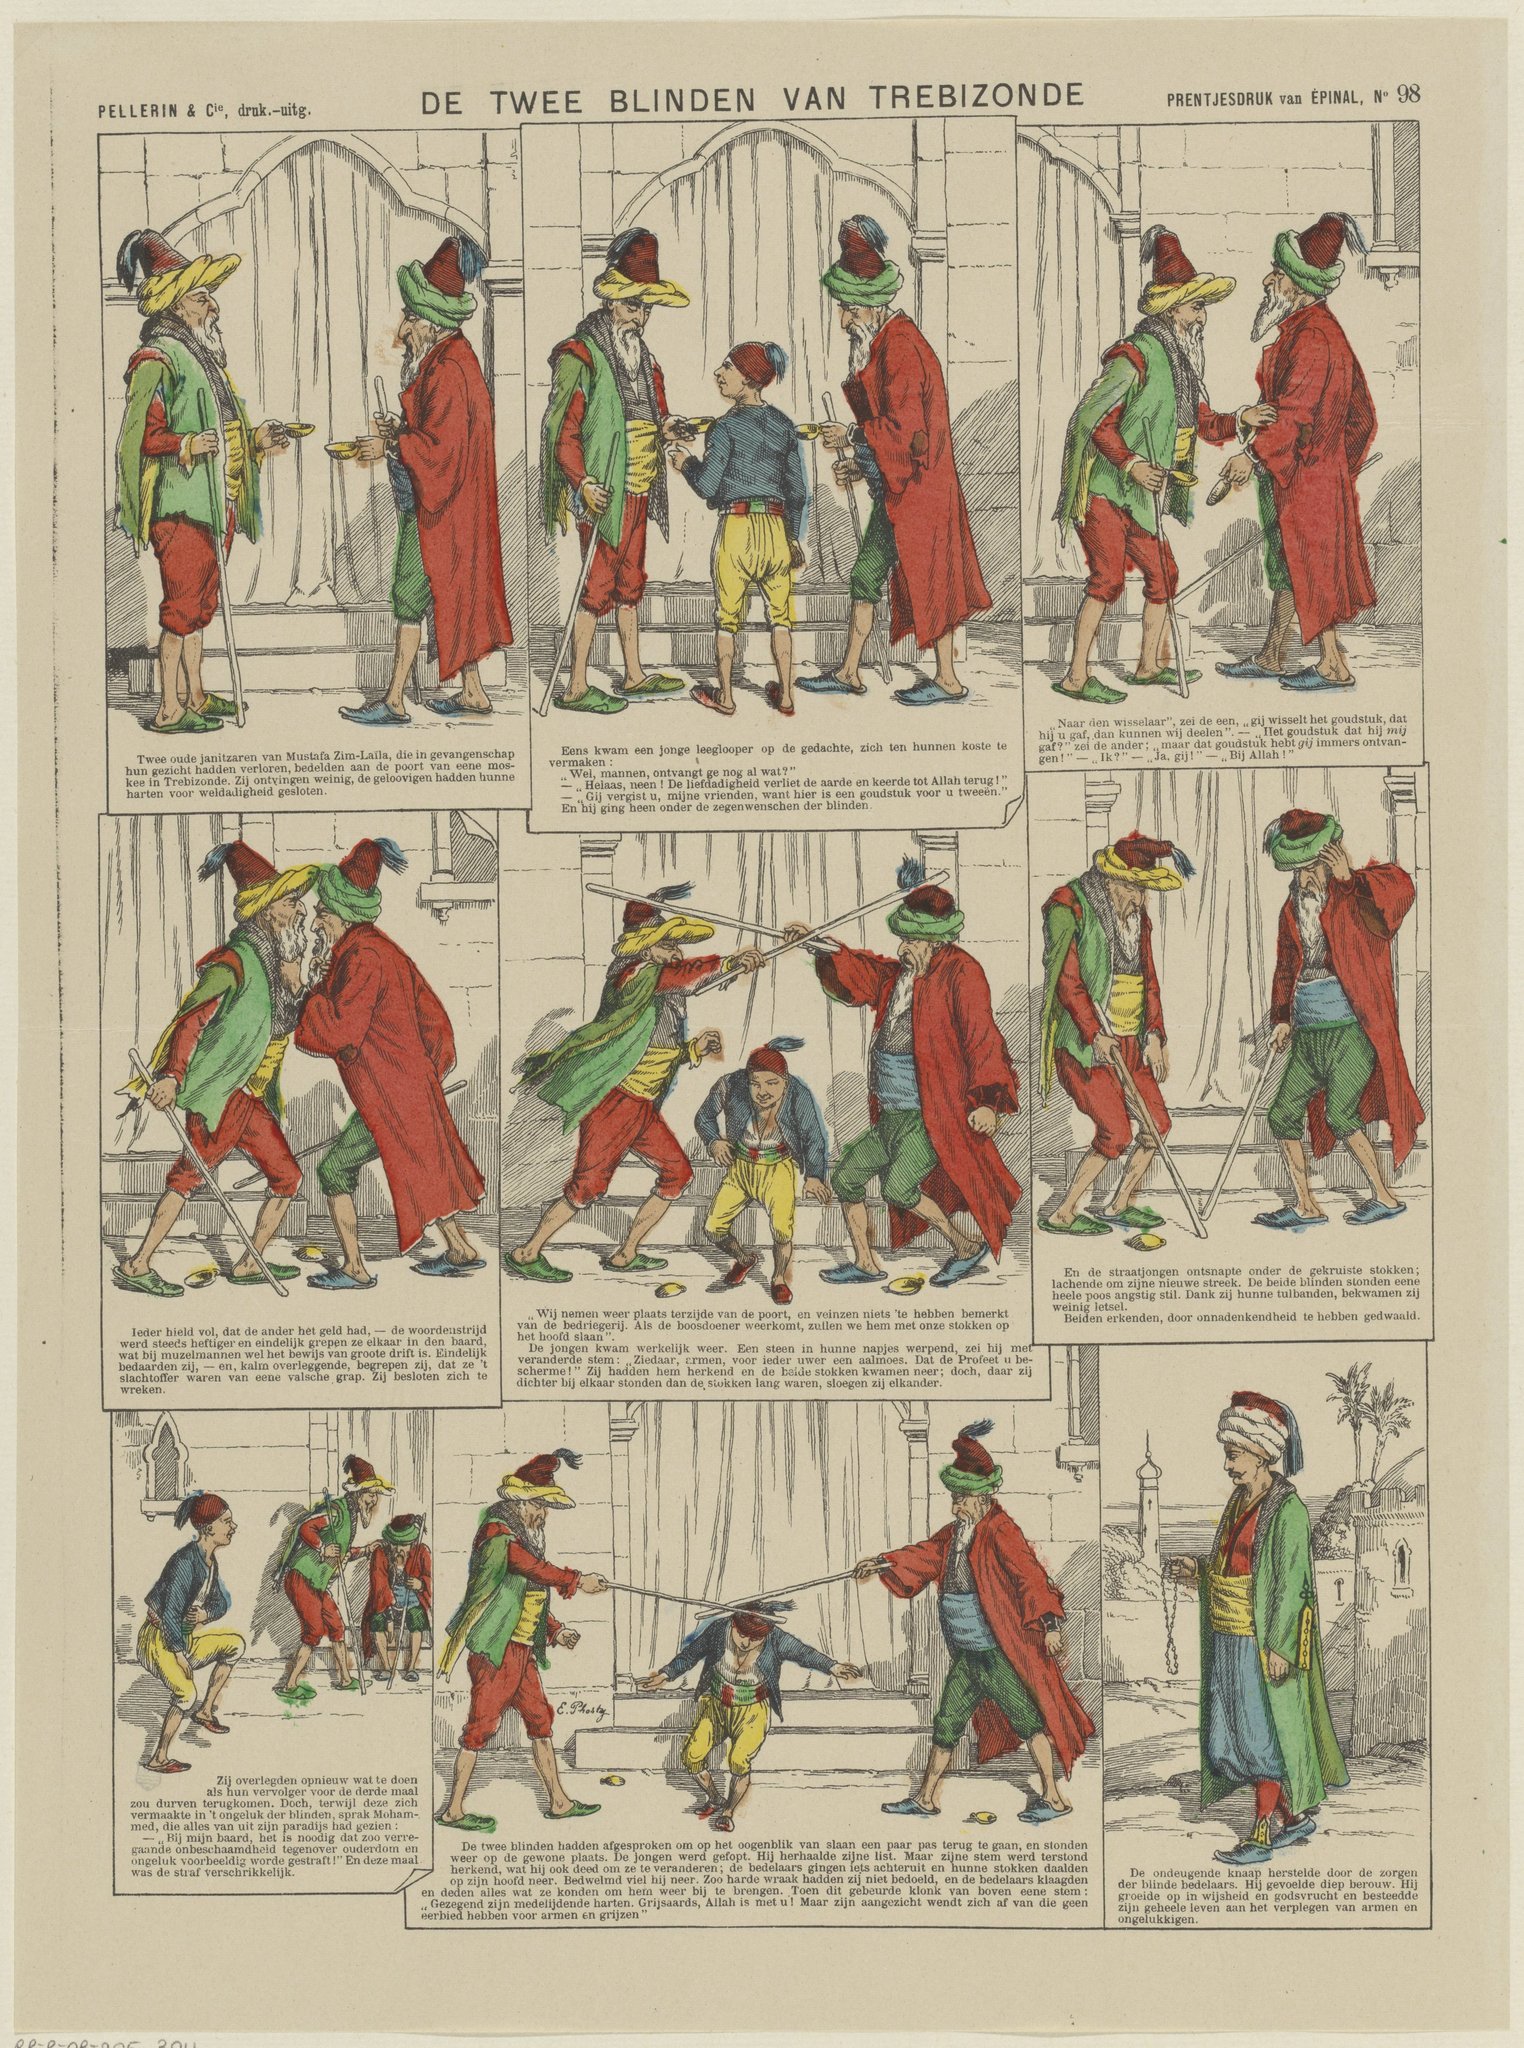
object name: print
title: Prentjesdruk van Epinal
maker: e. phosty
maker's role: print maker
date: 1902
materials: paper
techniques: colour, letterpress printing, lithograph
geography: epinal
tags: blind, blindness, beggar, fighting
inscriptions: collector's mark: Lugt 2760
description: Blad met 9 voorstellingen van twee blinde mannen die met elkaar vechten. Onder elke afbeelding een onderschrift. Genummerd rechtsboven: No 98.